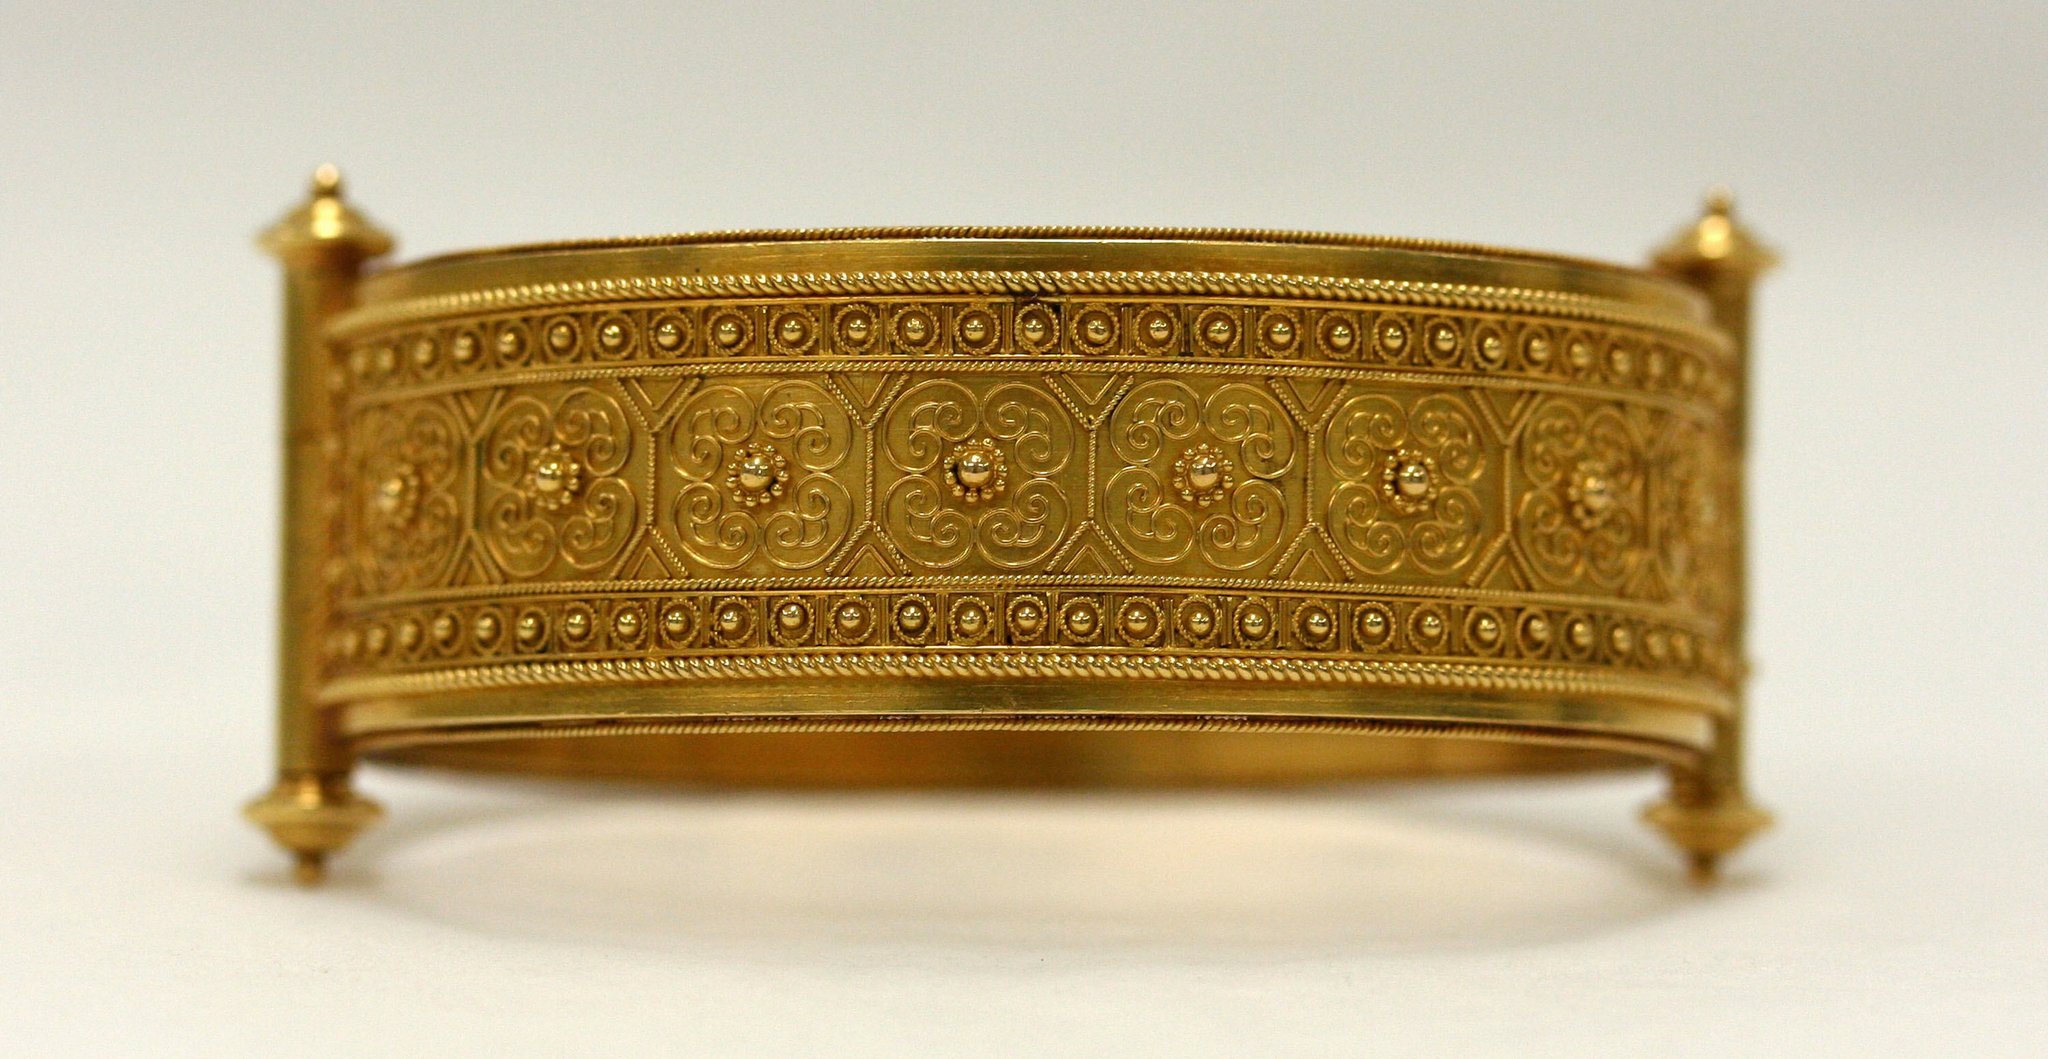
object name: bracelet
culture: european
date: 1860-1869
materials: gold